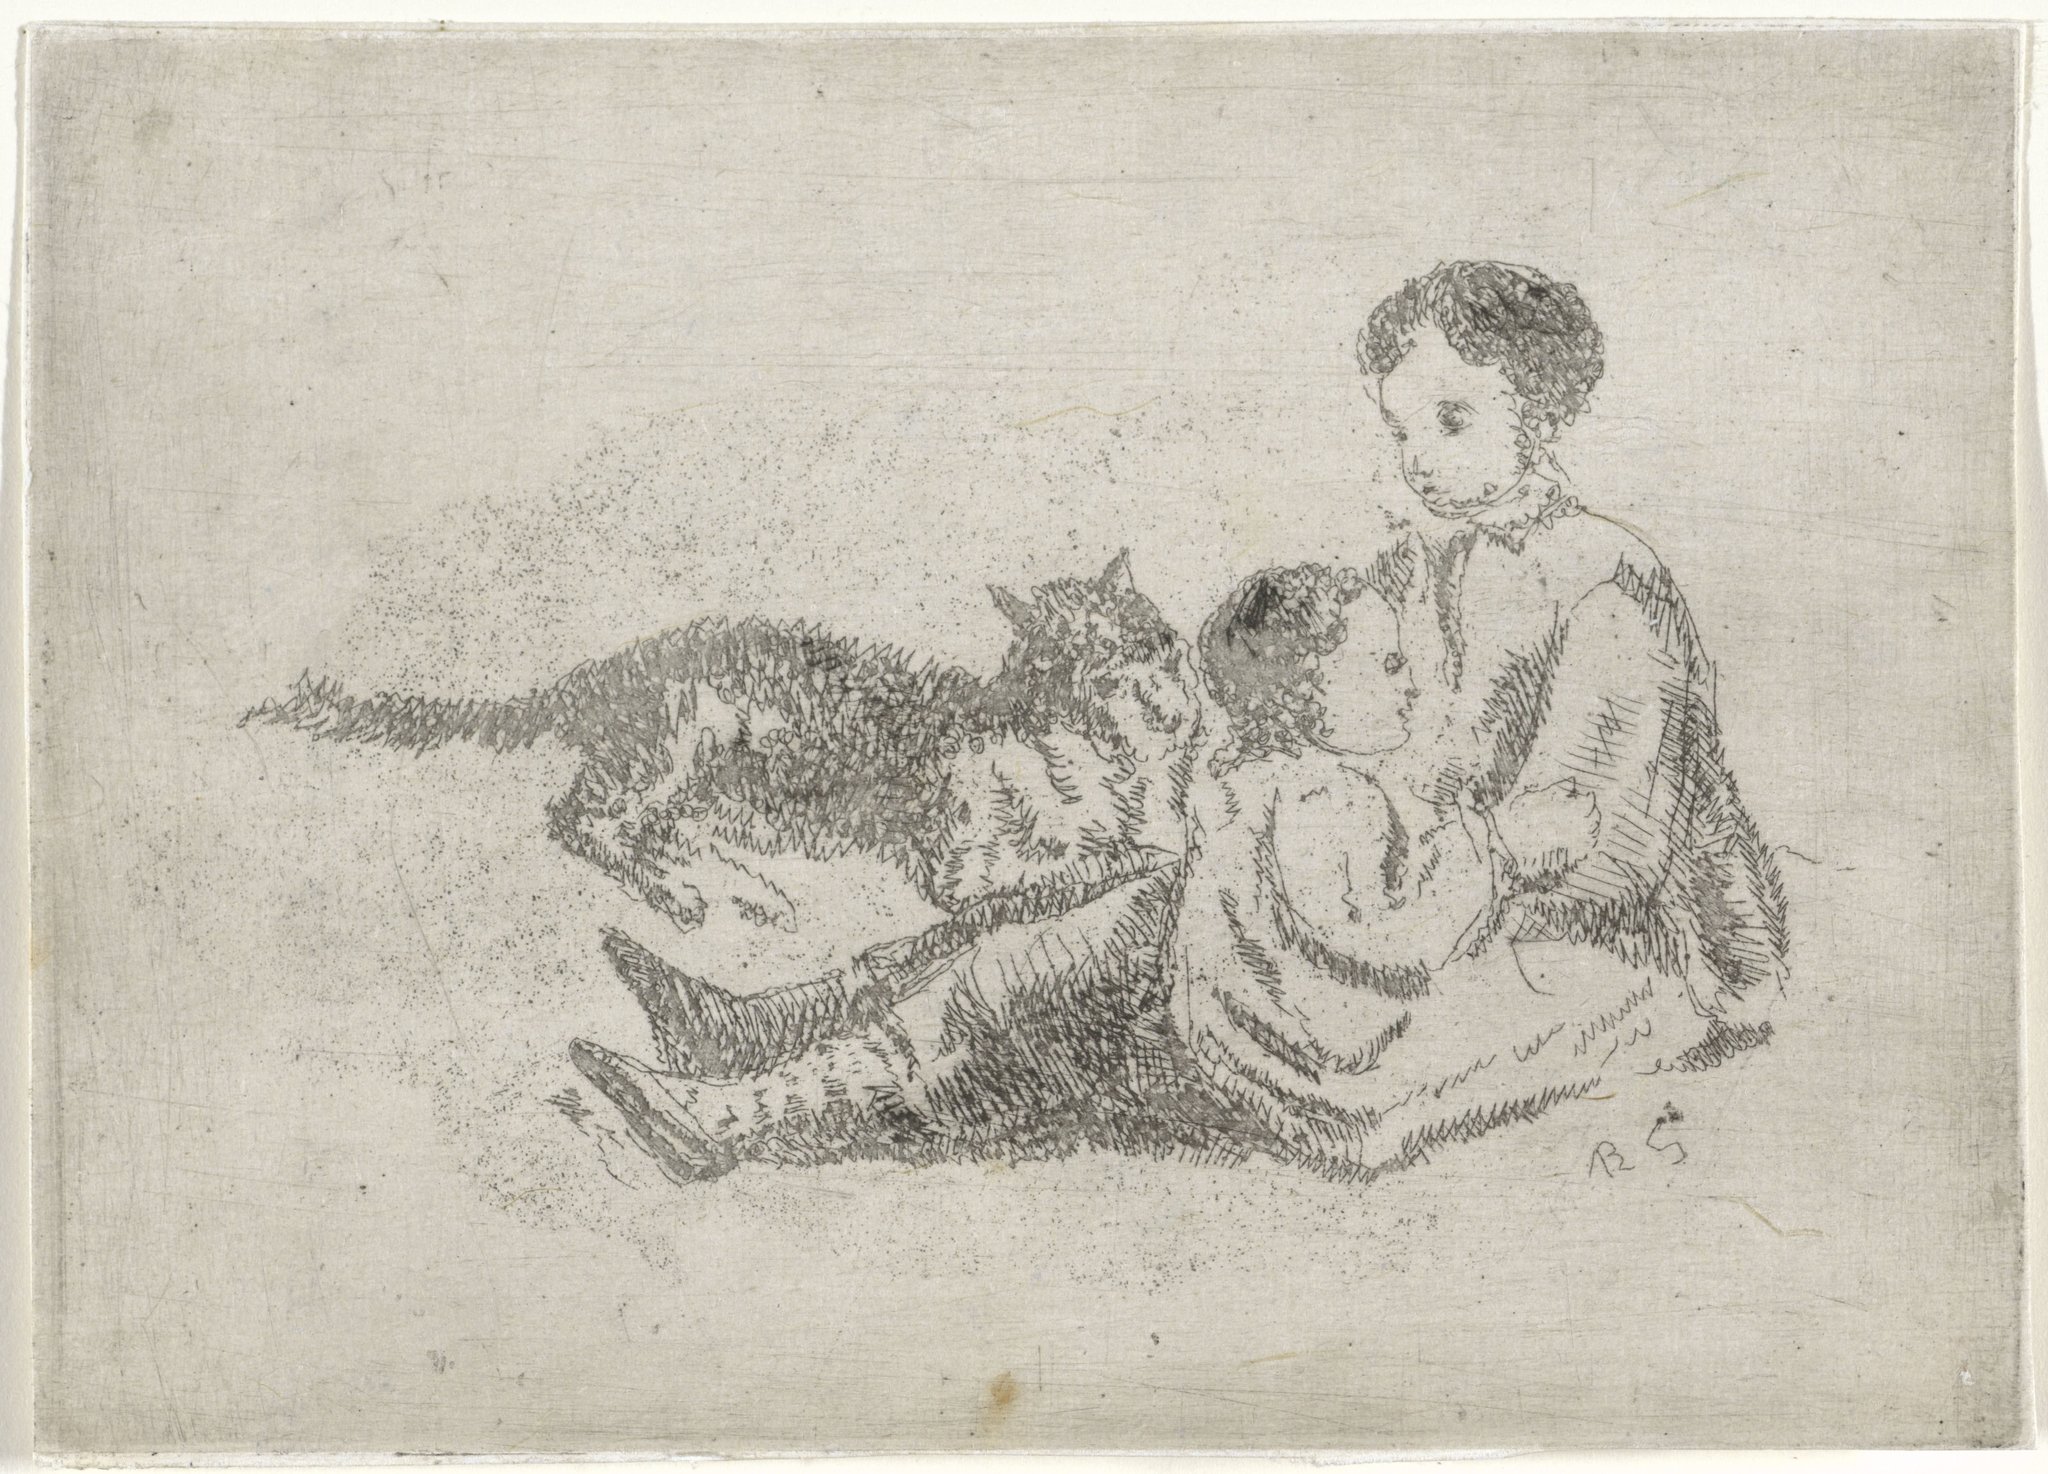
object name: print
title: Kinderen met een poes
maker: arnoud schaepkens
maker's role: print maker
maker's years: 1816-1904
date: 1831-1904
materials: paper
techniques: drypoint, etching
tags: cat, child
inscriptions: collector's mark: Lugt 2228